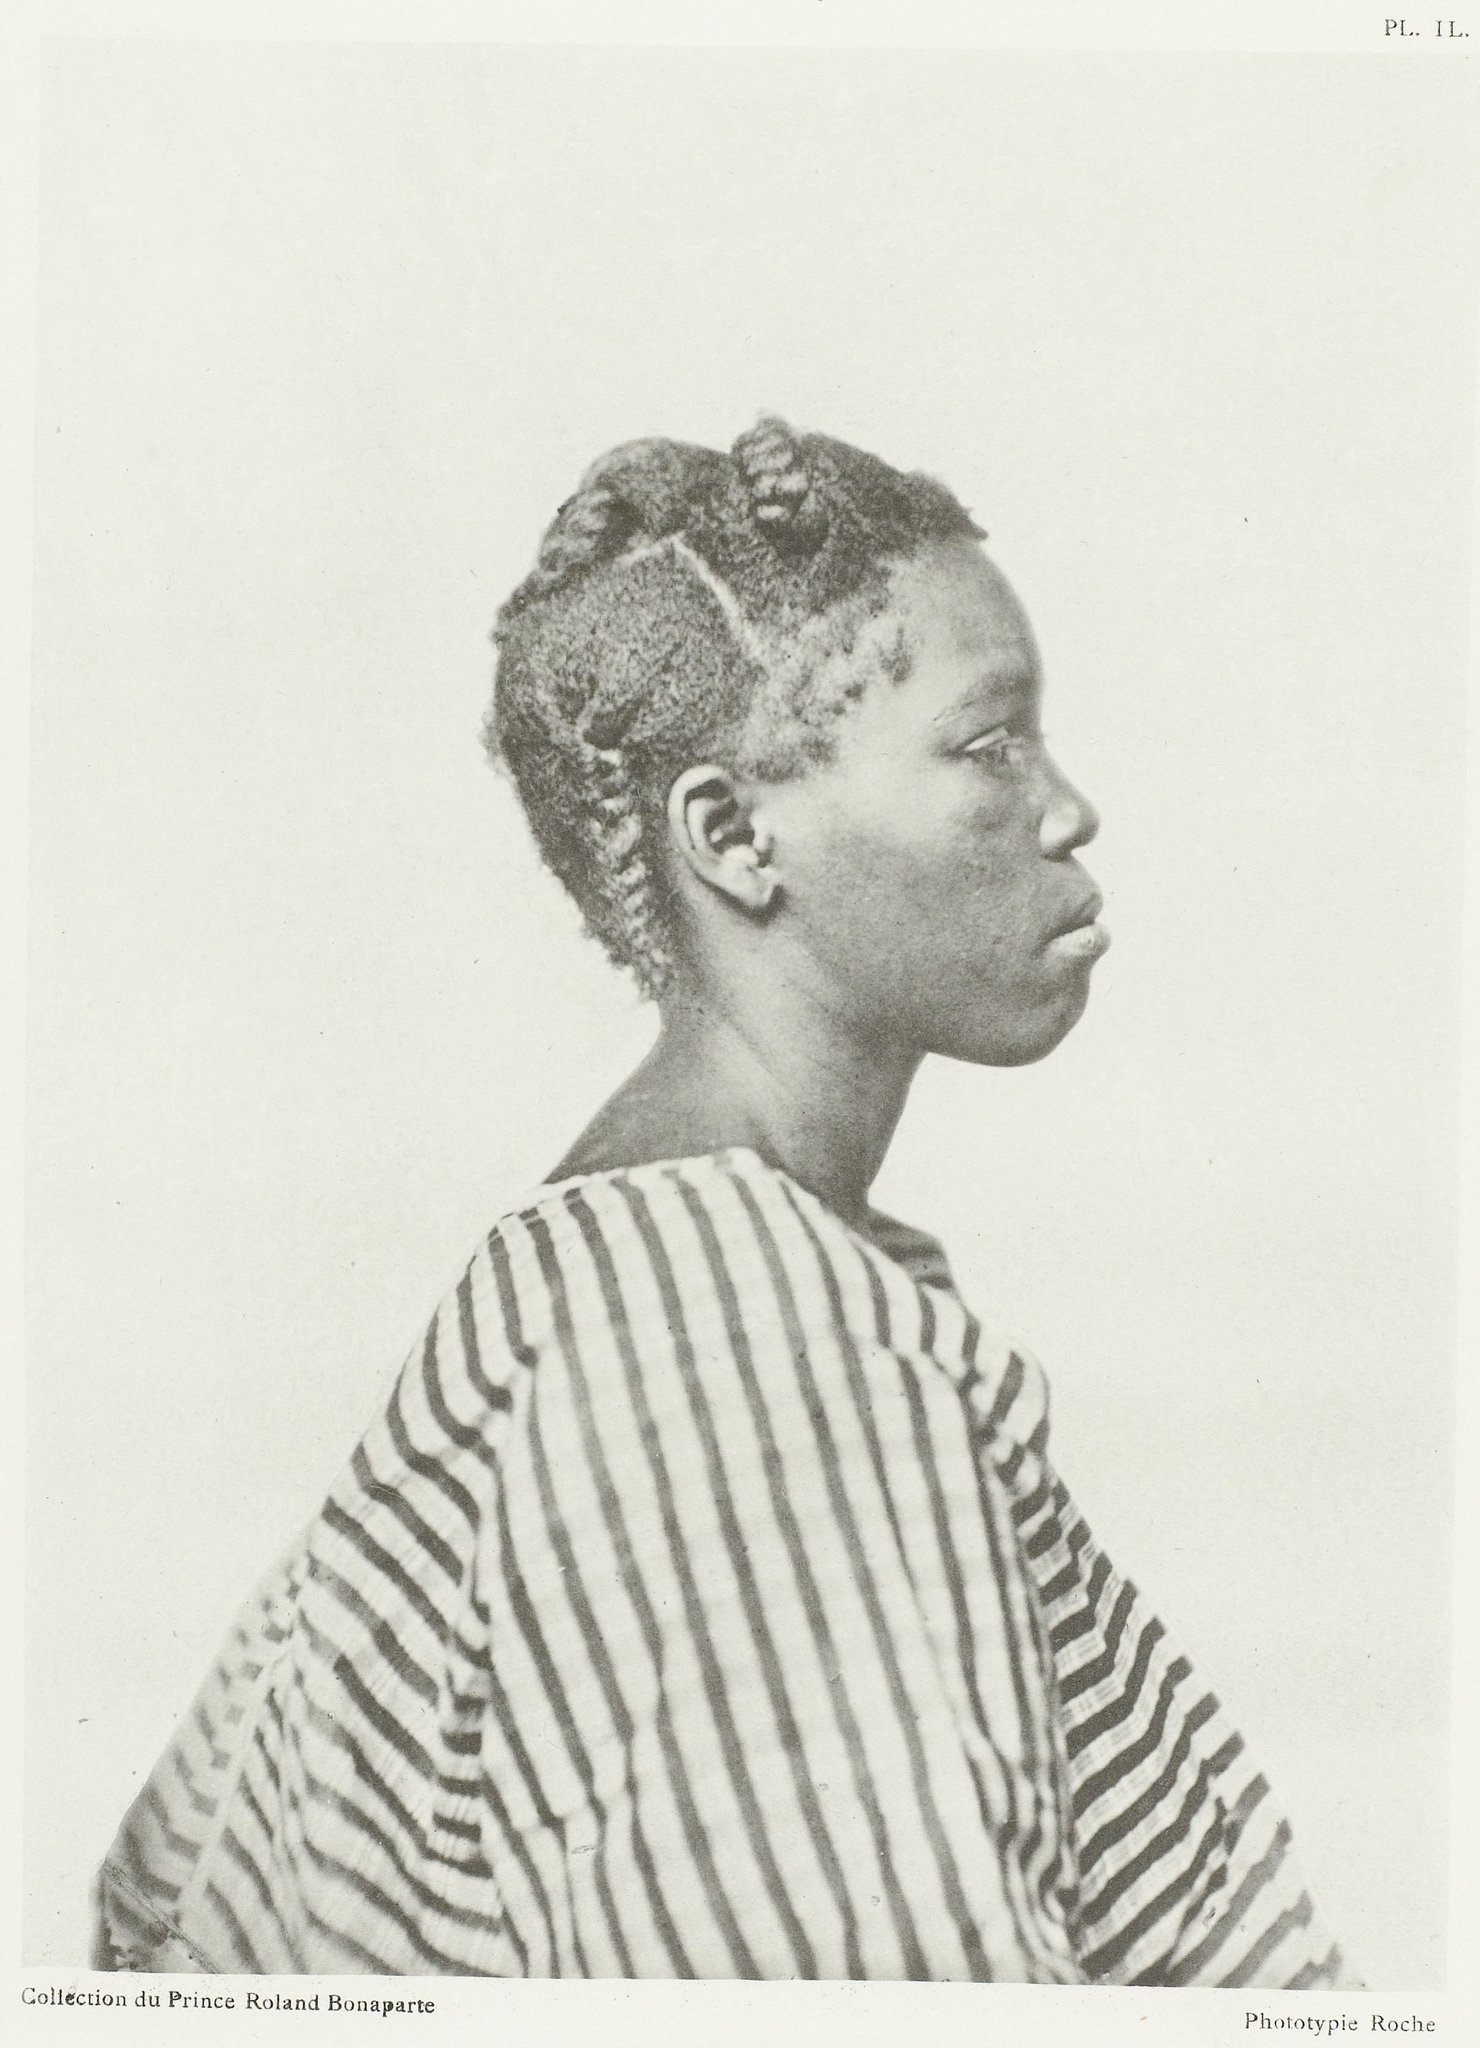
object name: page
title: Portret van Elisabeth Oldenberg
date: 1883-1884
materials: paper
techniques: photograph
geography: amsterdam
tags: adult woman, historical persons, amsterdam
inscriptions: inscription: ‘Collection du Prince Roland Bonaparte/ Phototypie Roche’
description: Portret van Elisabeth Oldenberg, een Surinaamse vrouw van Afrikaanse oorsprong, gefotografeerd op de Internationale Koloniale en Uitvoerhandel Tentoonstelling, Amsterdam 1883.